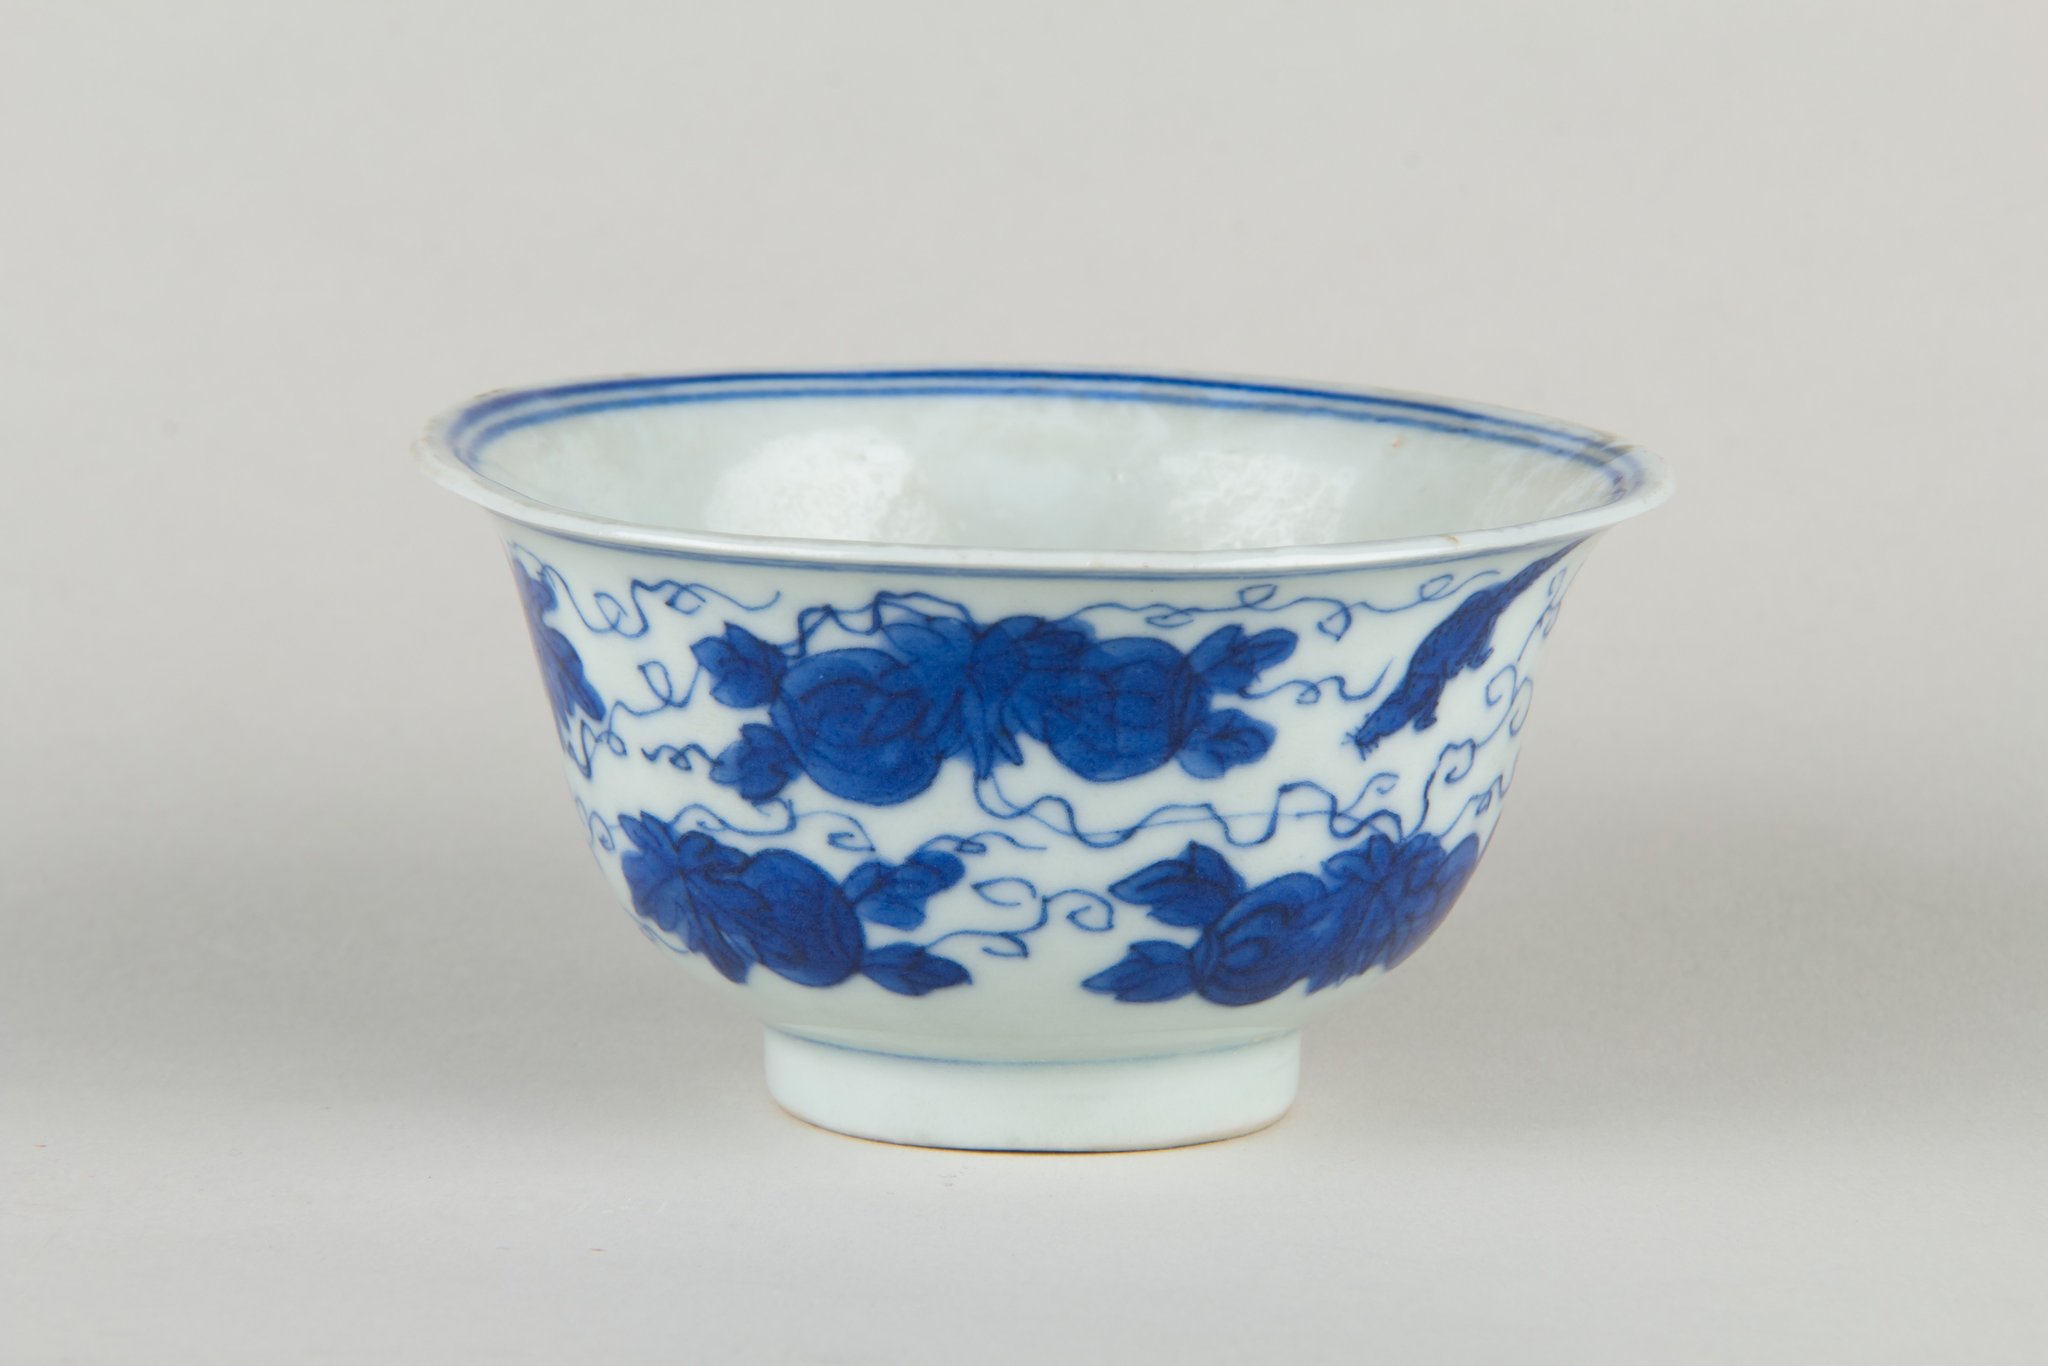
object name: bowl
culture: chinese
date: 1368-1644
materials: cobalt, glaze, porcelain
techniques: painting